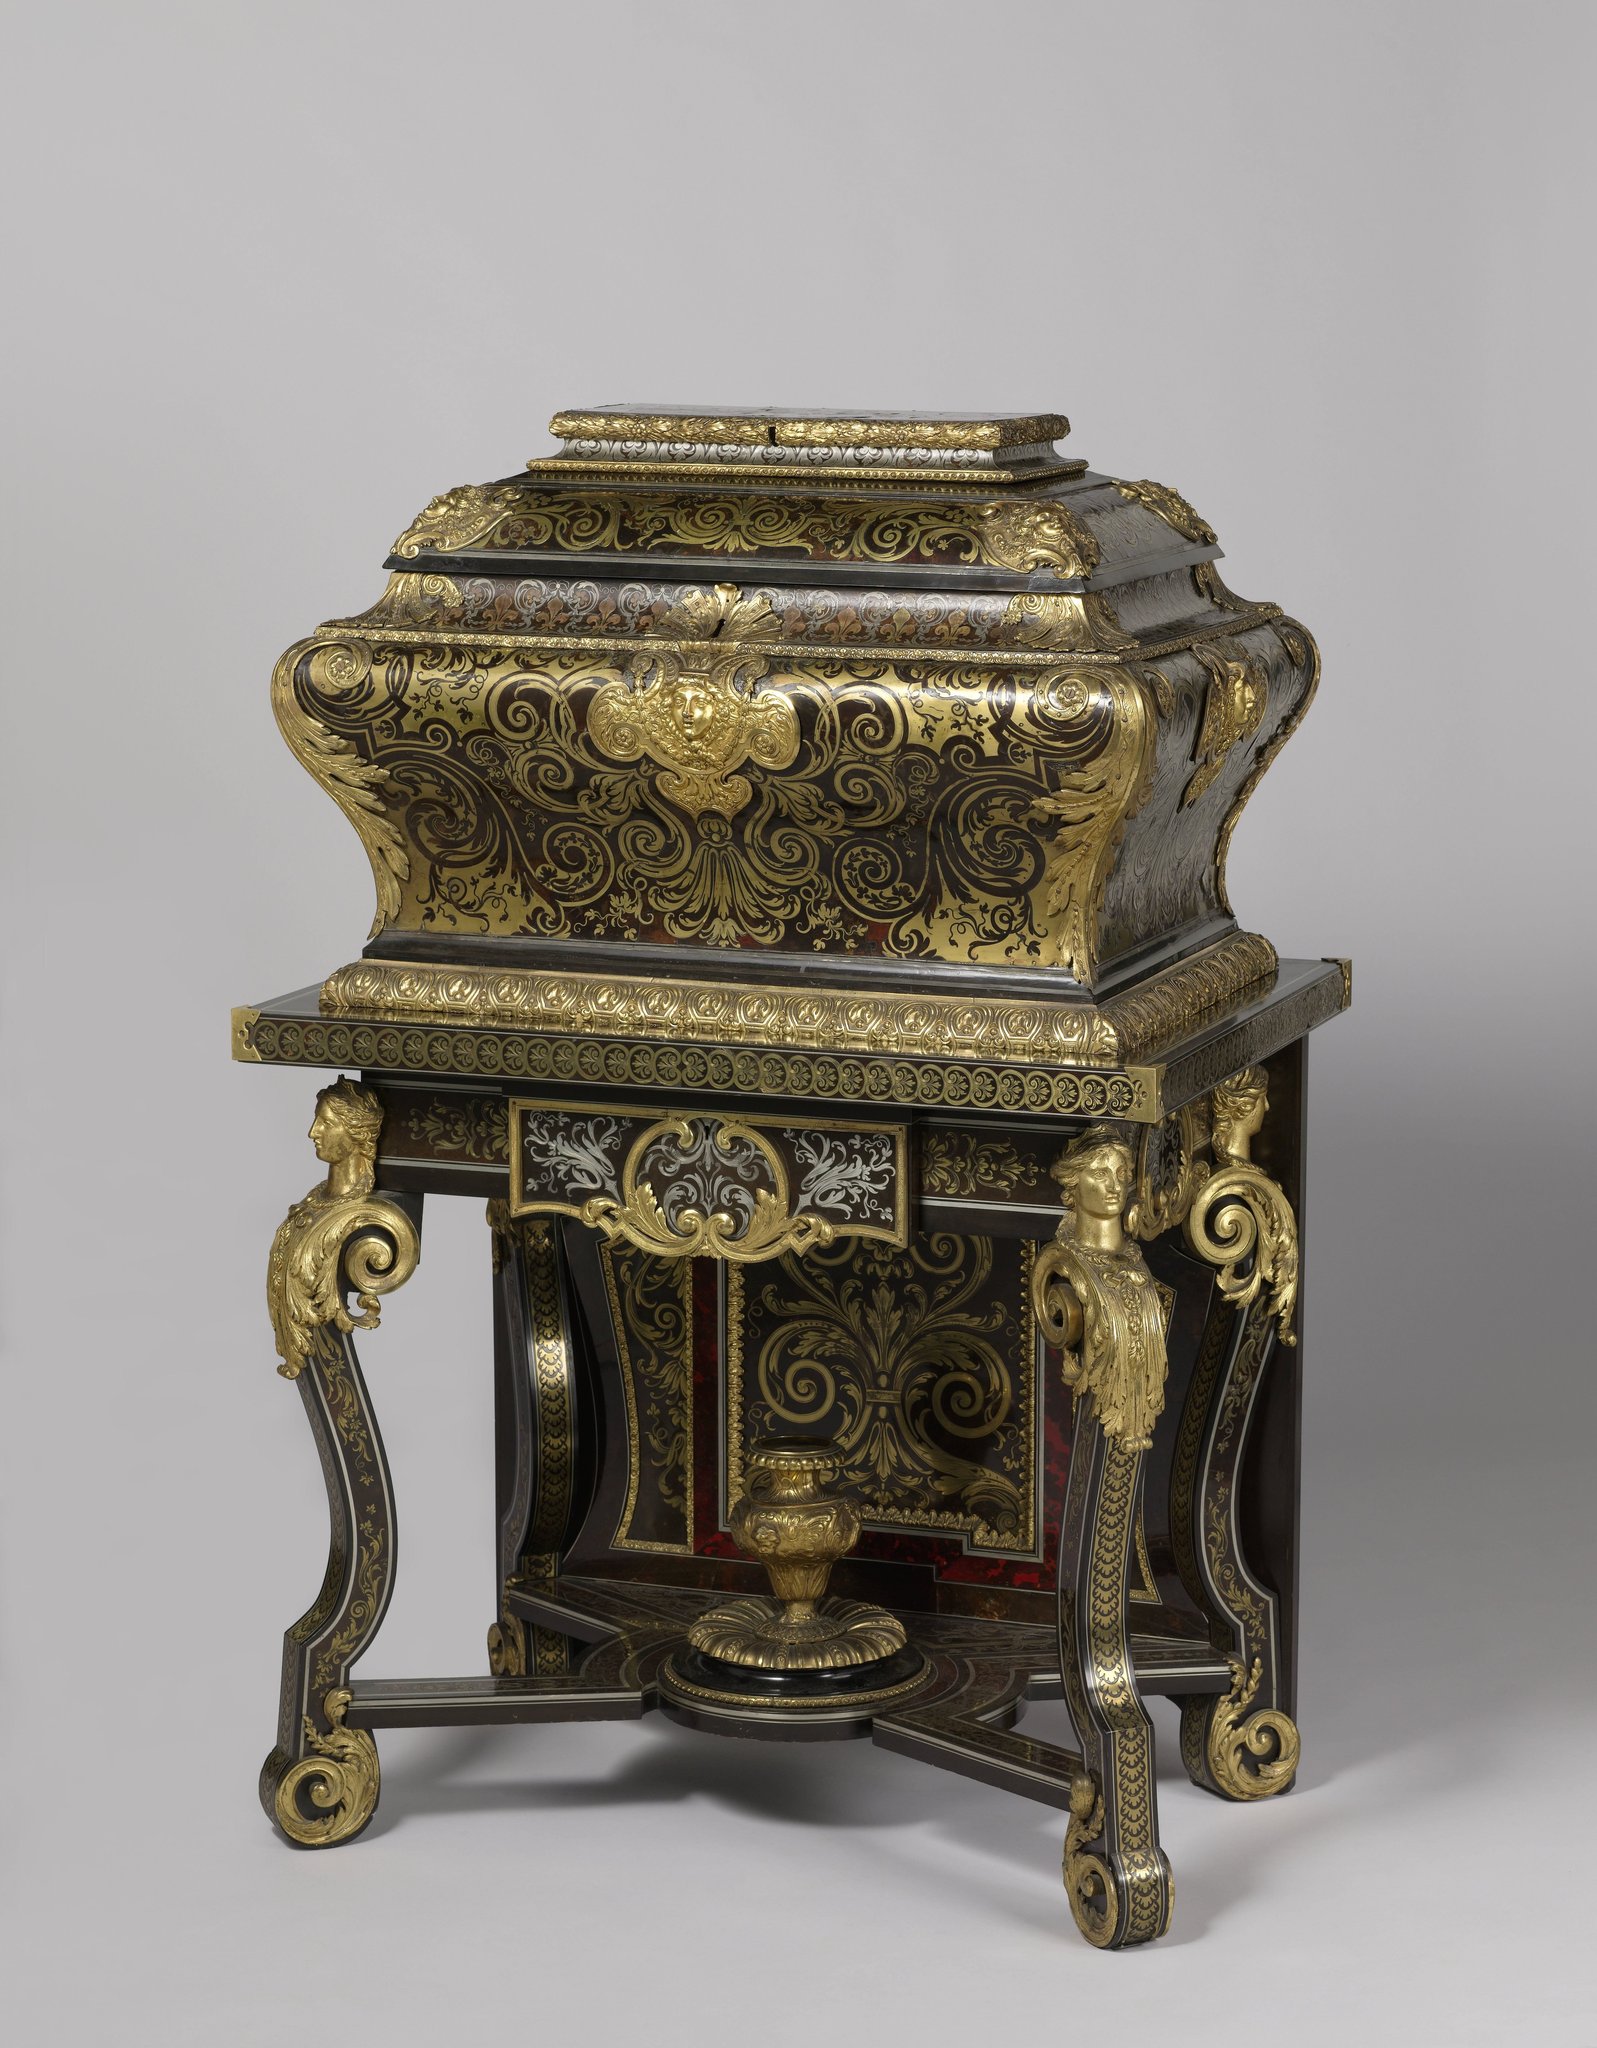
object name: suitcase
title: Two toilet caskets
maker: andré-charles boulle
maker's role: print maker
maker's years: 1642-1732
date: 1685-1690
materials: brass, bronze, wood, iron, tin, shell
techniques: marquetry, gilding, veneering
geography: paris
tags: ornament ~ human parts, mask, mascaron ~ ornament, head (human) - aa - female human figure, foliage, tendrils, branches ~ ornament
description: These caskets on stands probably served no practical purpose. They were made as works of art, to add lustre to a princely chamber. They are ornamented with marquetry of tortoiseshell and brass, supplemented with some pewter. Boulle specialized in this technique, which is known as boullework. The shape of the fittings accords well with the patterns of the marquetry.